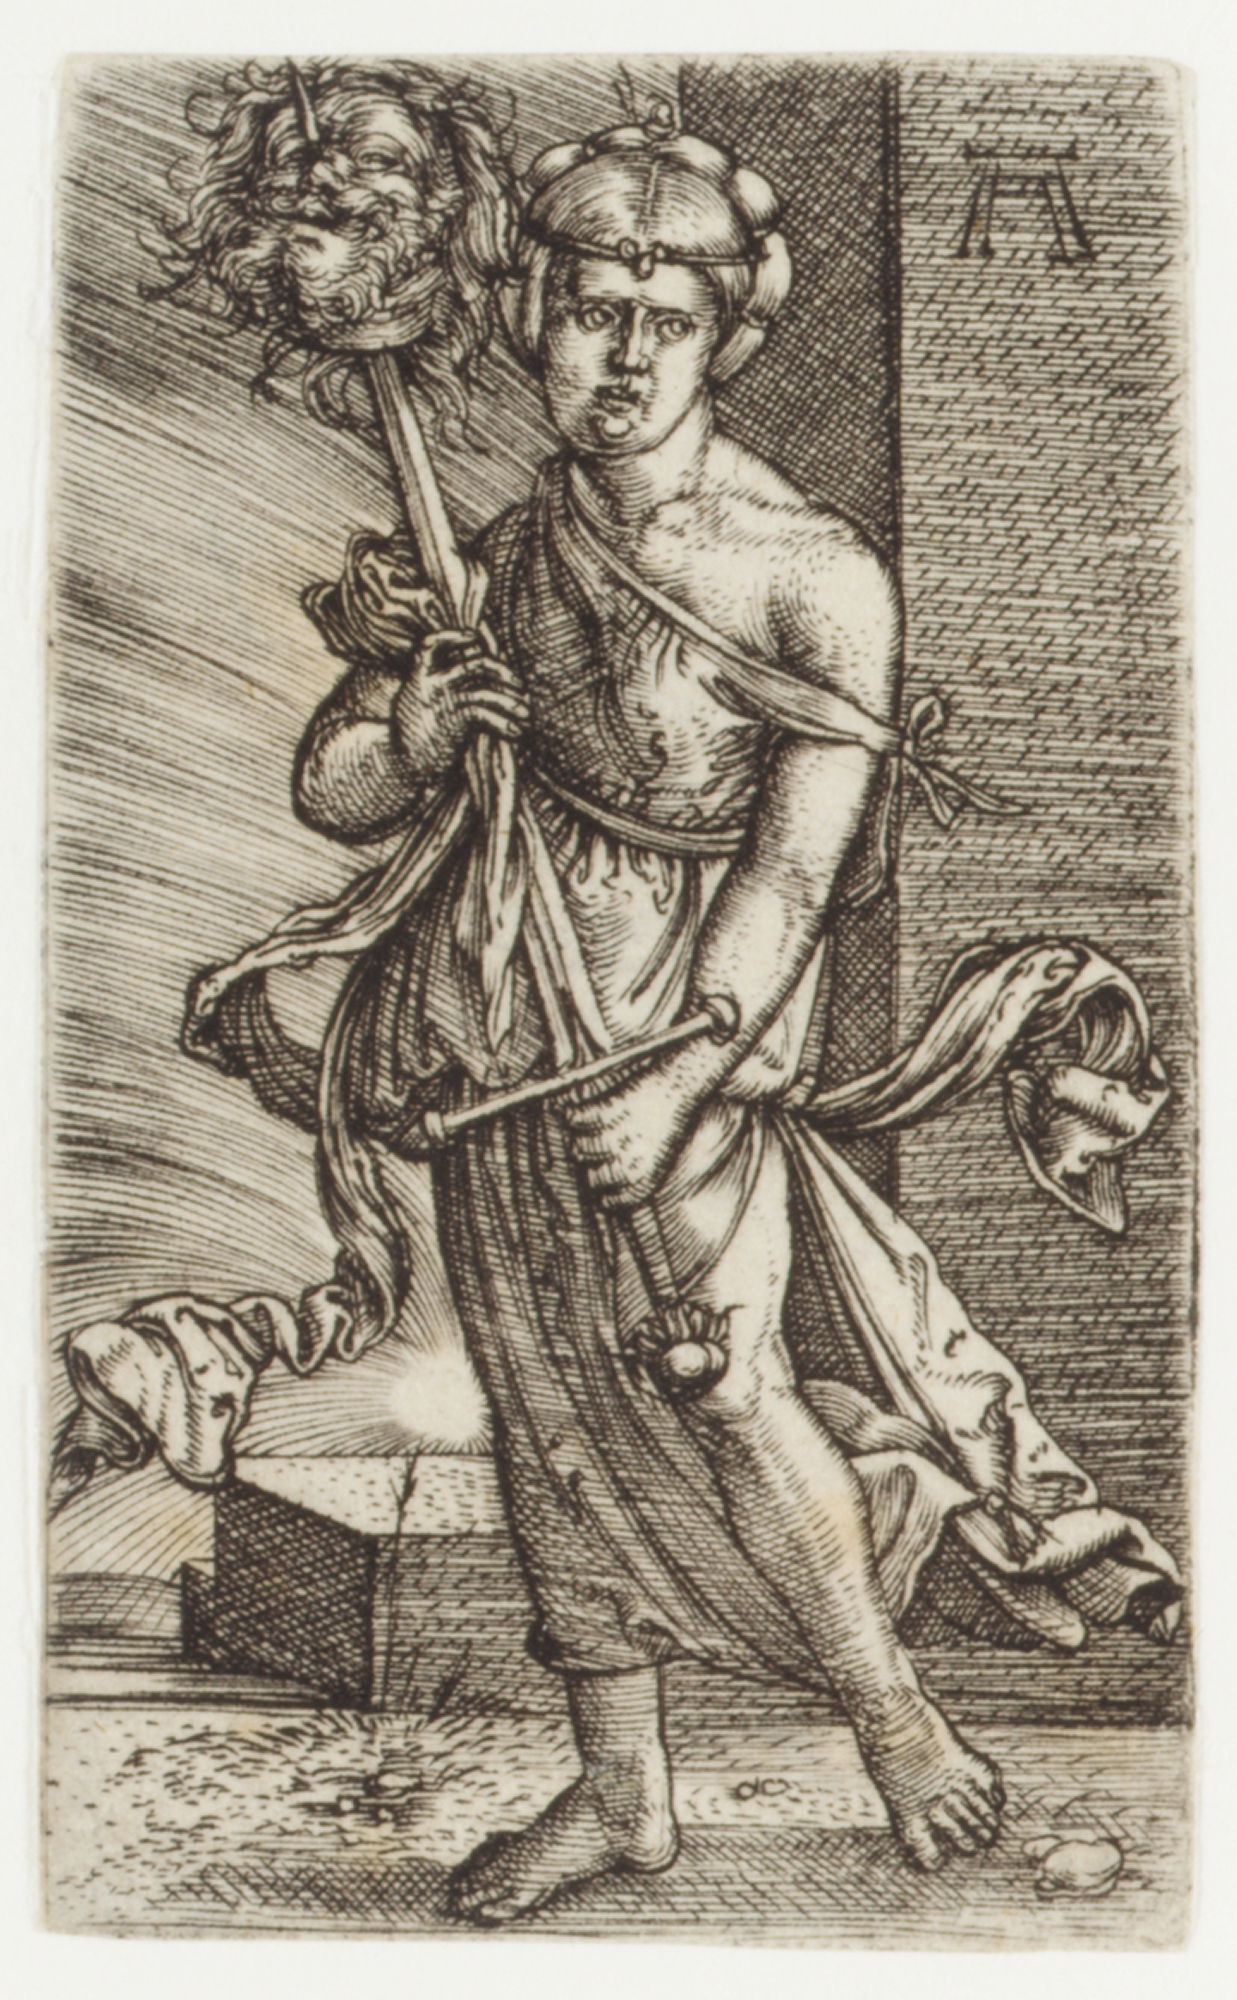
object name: print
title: Judith with the Head of Holofernes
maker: albrecht altdorfer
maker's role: artist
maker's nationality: german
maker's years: 1480-1538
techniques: engraving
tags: holofernes,judith